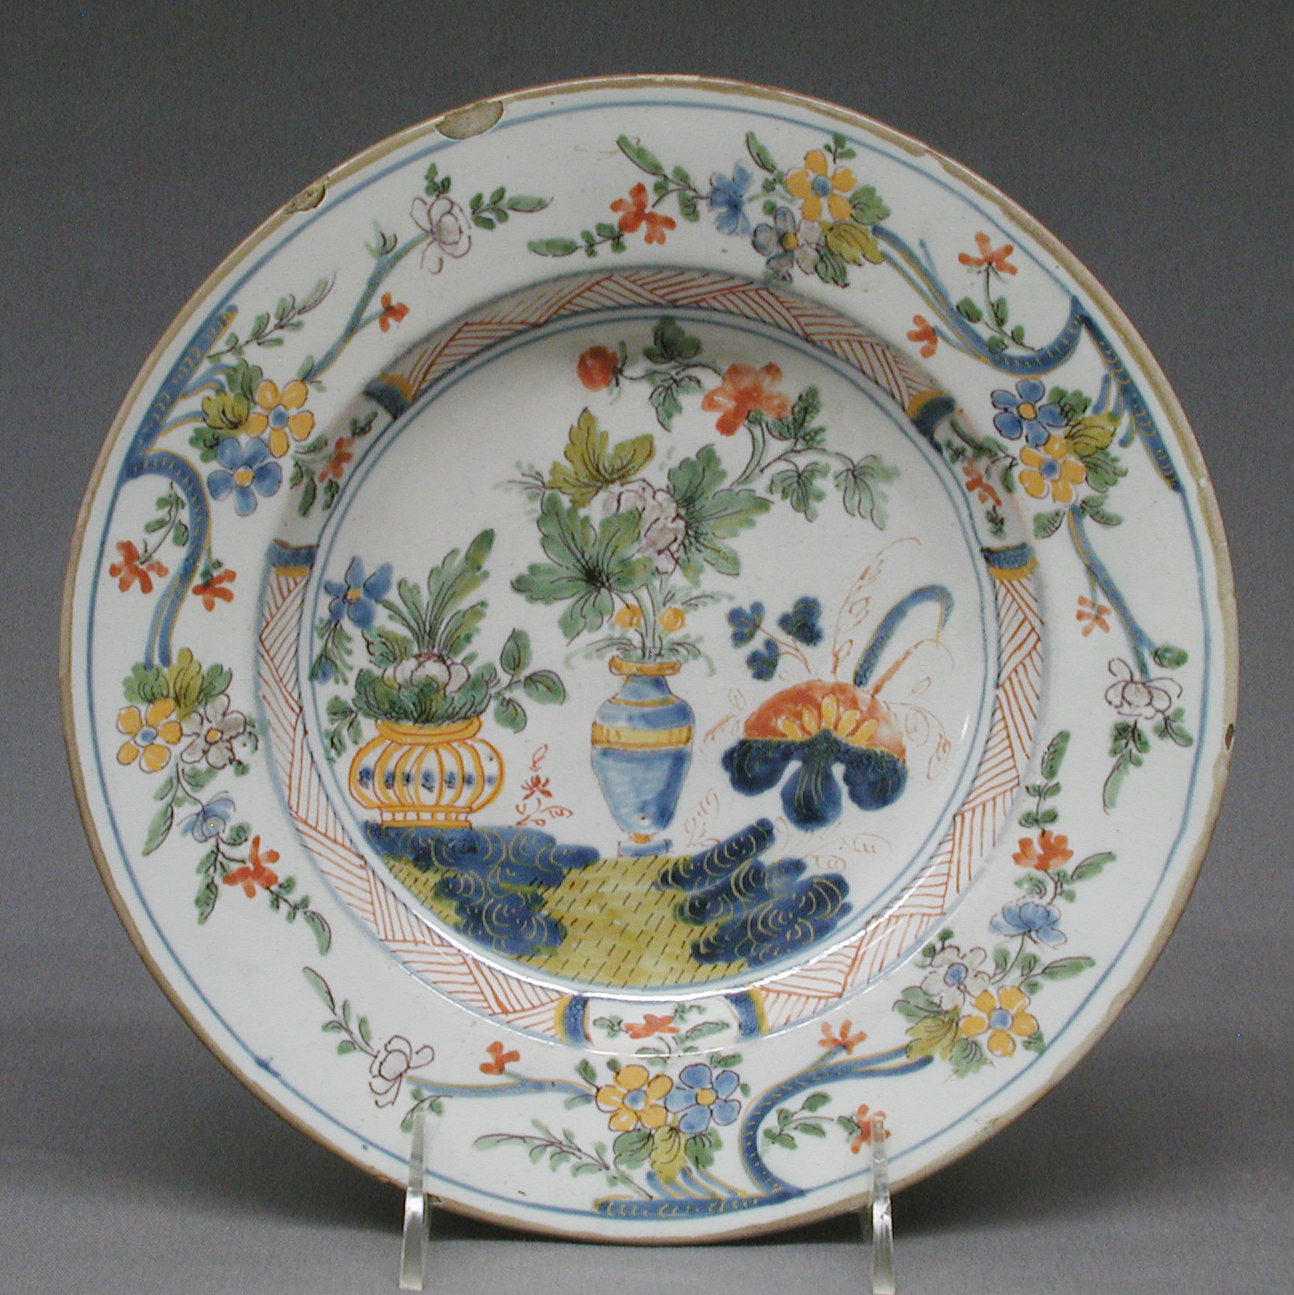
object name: plate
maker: ferniani manufactory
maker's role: manufactory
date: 1701-1800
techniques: maiolica, glazing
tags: flowers